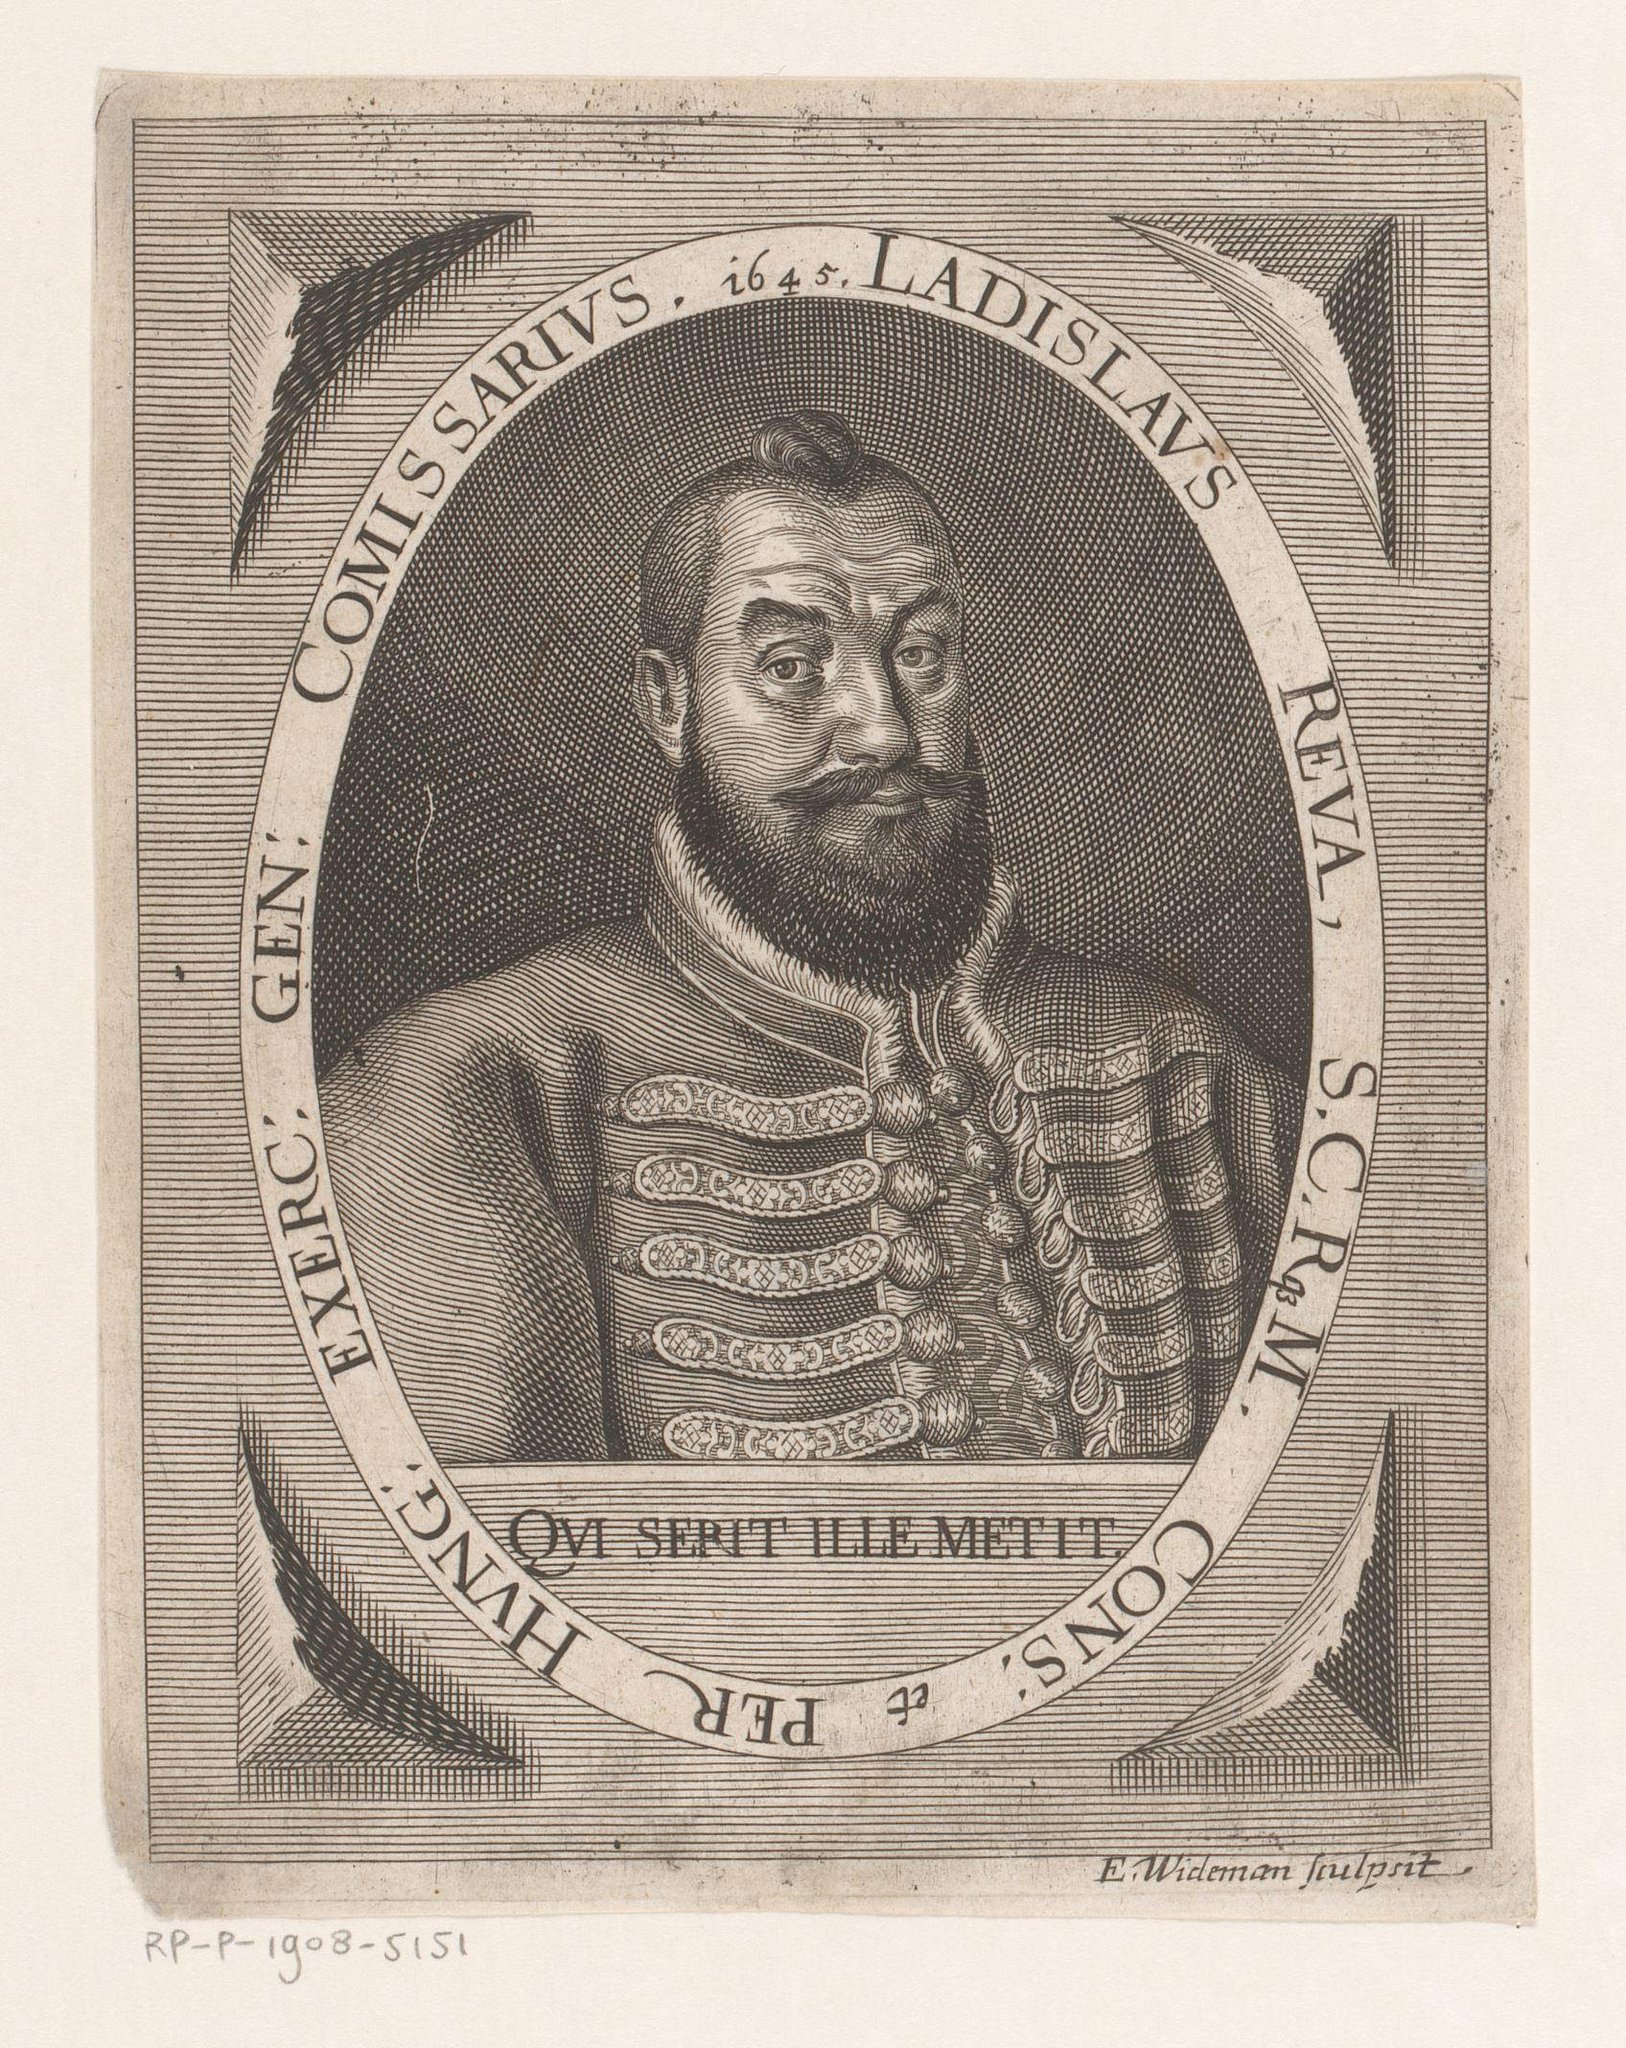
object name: print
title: Portret van Ladislav Révai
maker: elias widemann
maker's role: print maker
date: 1645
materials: paper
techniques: engraving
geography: vienna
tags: historical persons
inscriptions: collector's mark: Lugt 2228